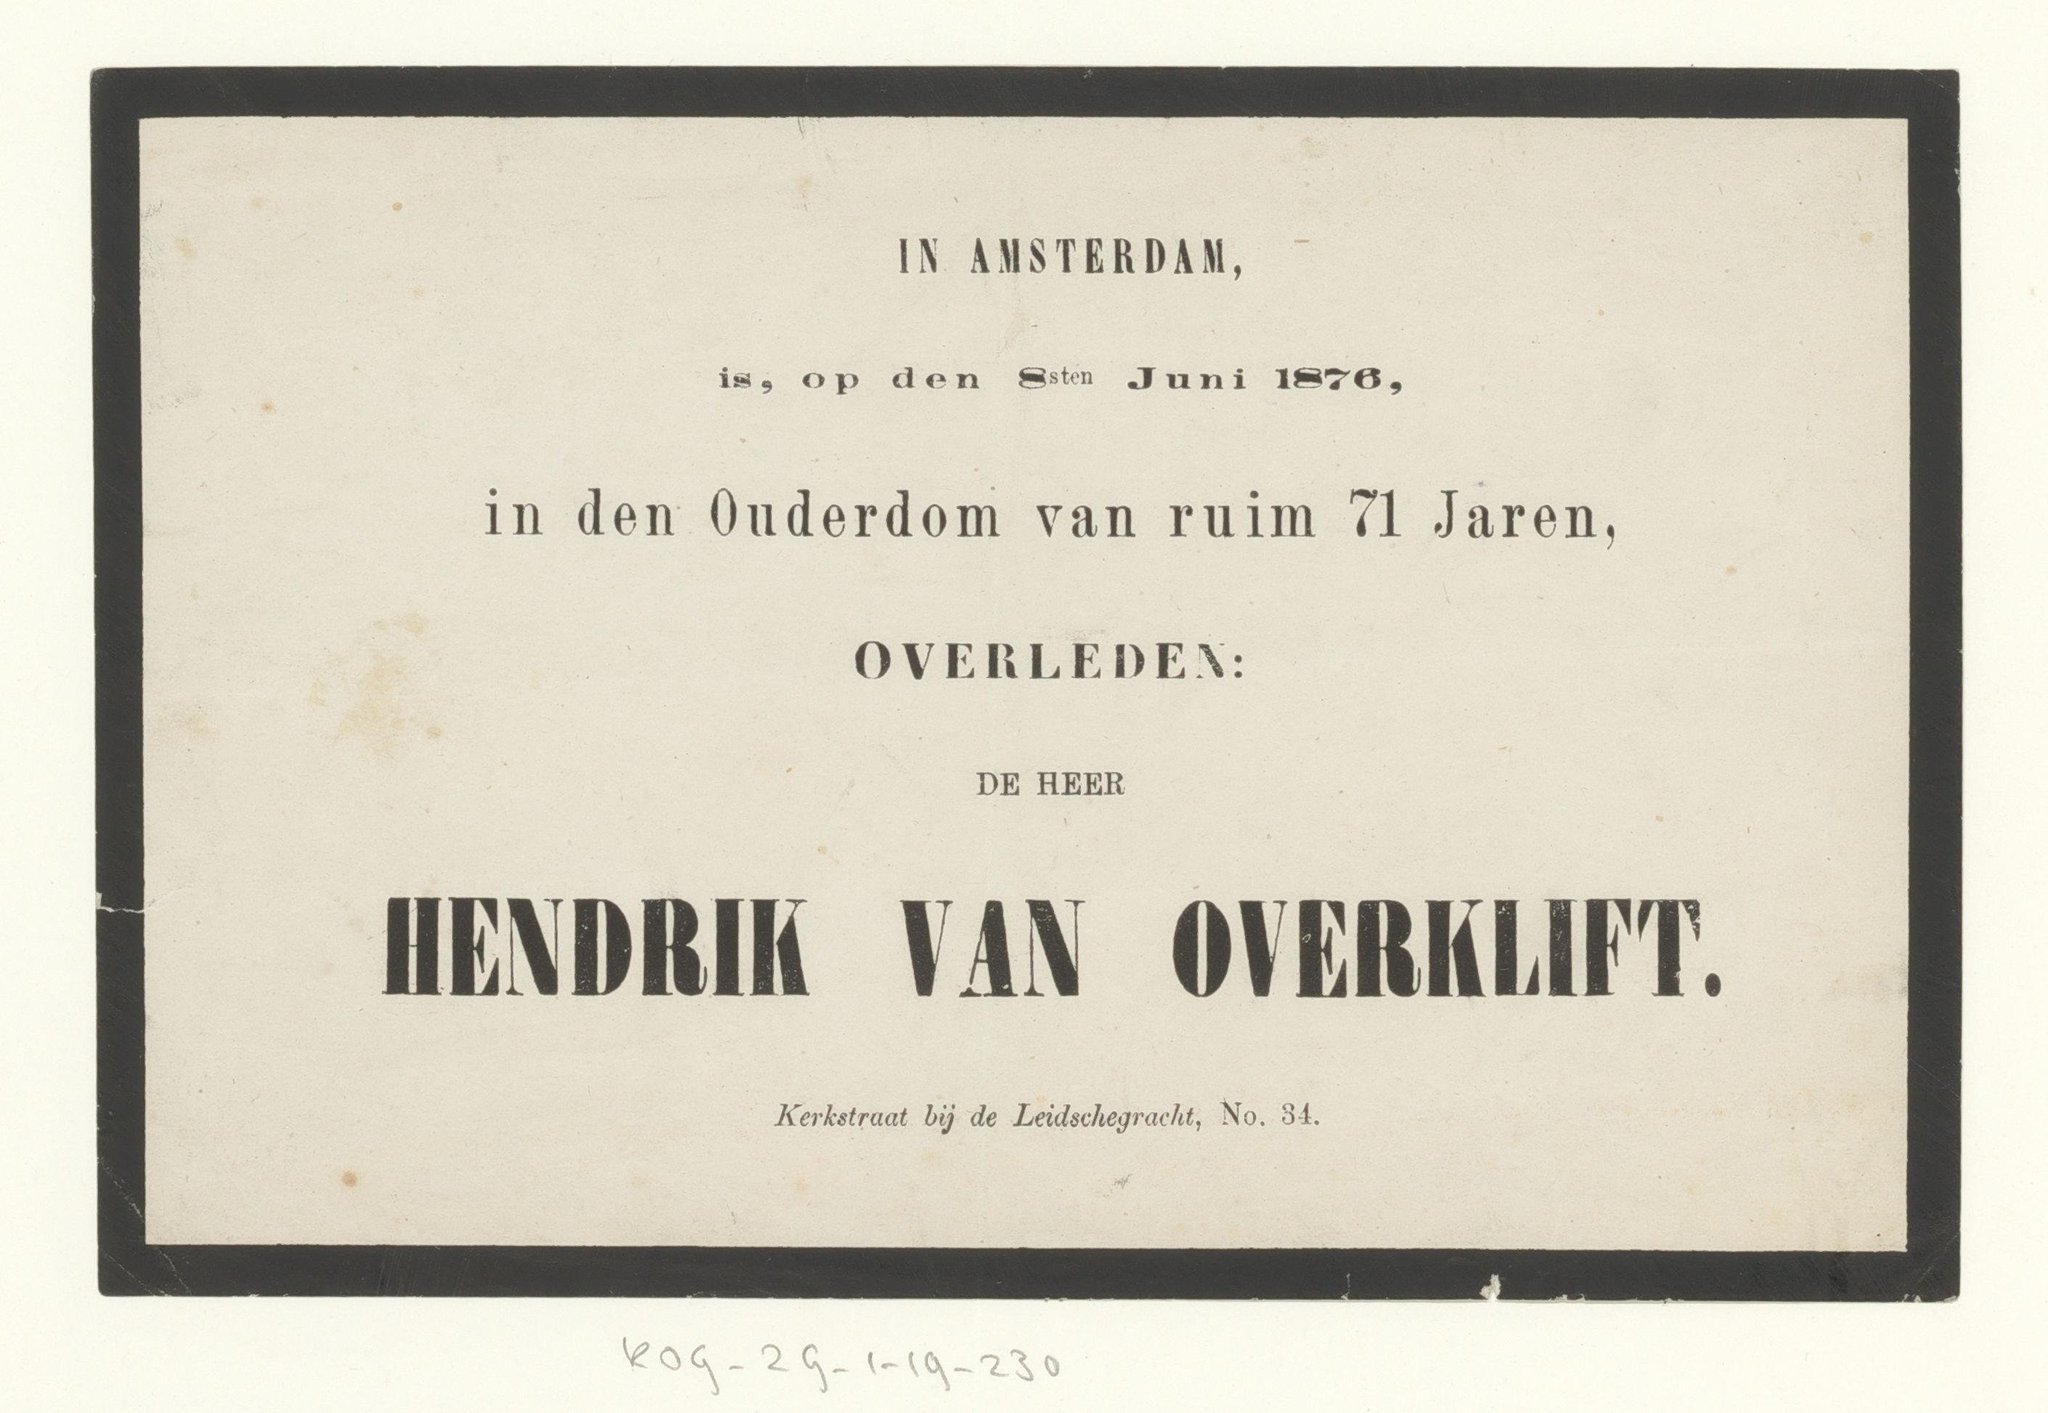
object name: overlijdensbericht, overlijdensadvertentie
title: Overlijdensbericht van Hendrik Overklift, 8 juni 1876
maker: Anonymous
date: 1806-1876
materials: paper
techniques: letterpress printing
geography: amsterdam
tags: mourning card, death notice, obituary, amsterdam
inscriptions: collector's mark, collector's mark: Lugt 1641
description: Overlijdensbericht met kennisgeving van het overlijden van Hendrik van Overklift, weduwnaar van Josina Margaretha Stultjes, op 8 juni 1876, te Amsterdam. Blad bedrukt met zwarte rouwranden. Onderwerpsrubrieken binnen de Atlas Zeden en Gewoonten: Des Menschen Begin, Midden en Einde. Begrafenissen, begrafenisbriefjes.